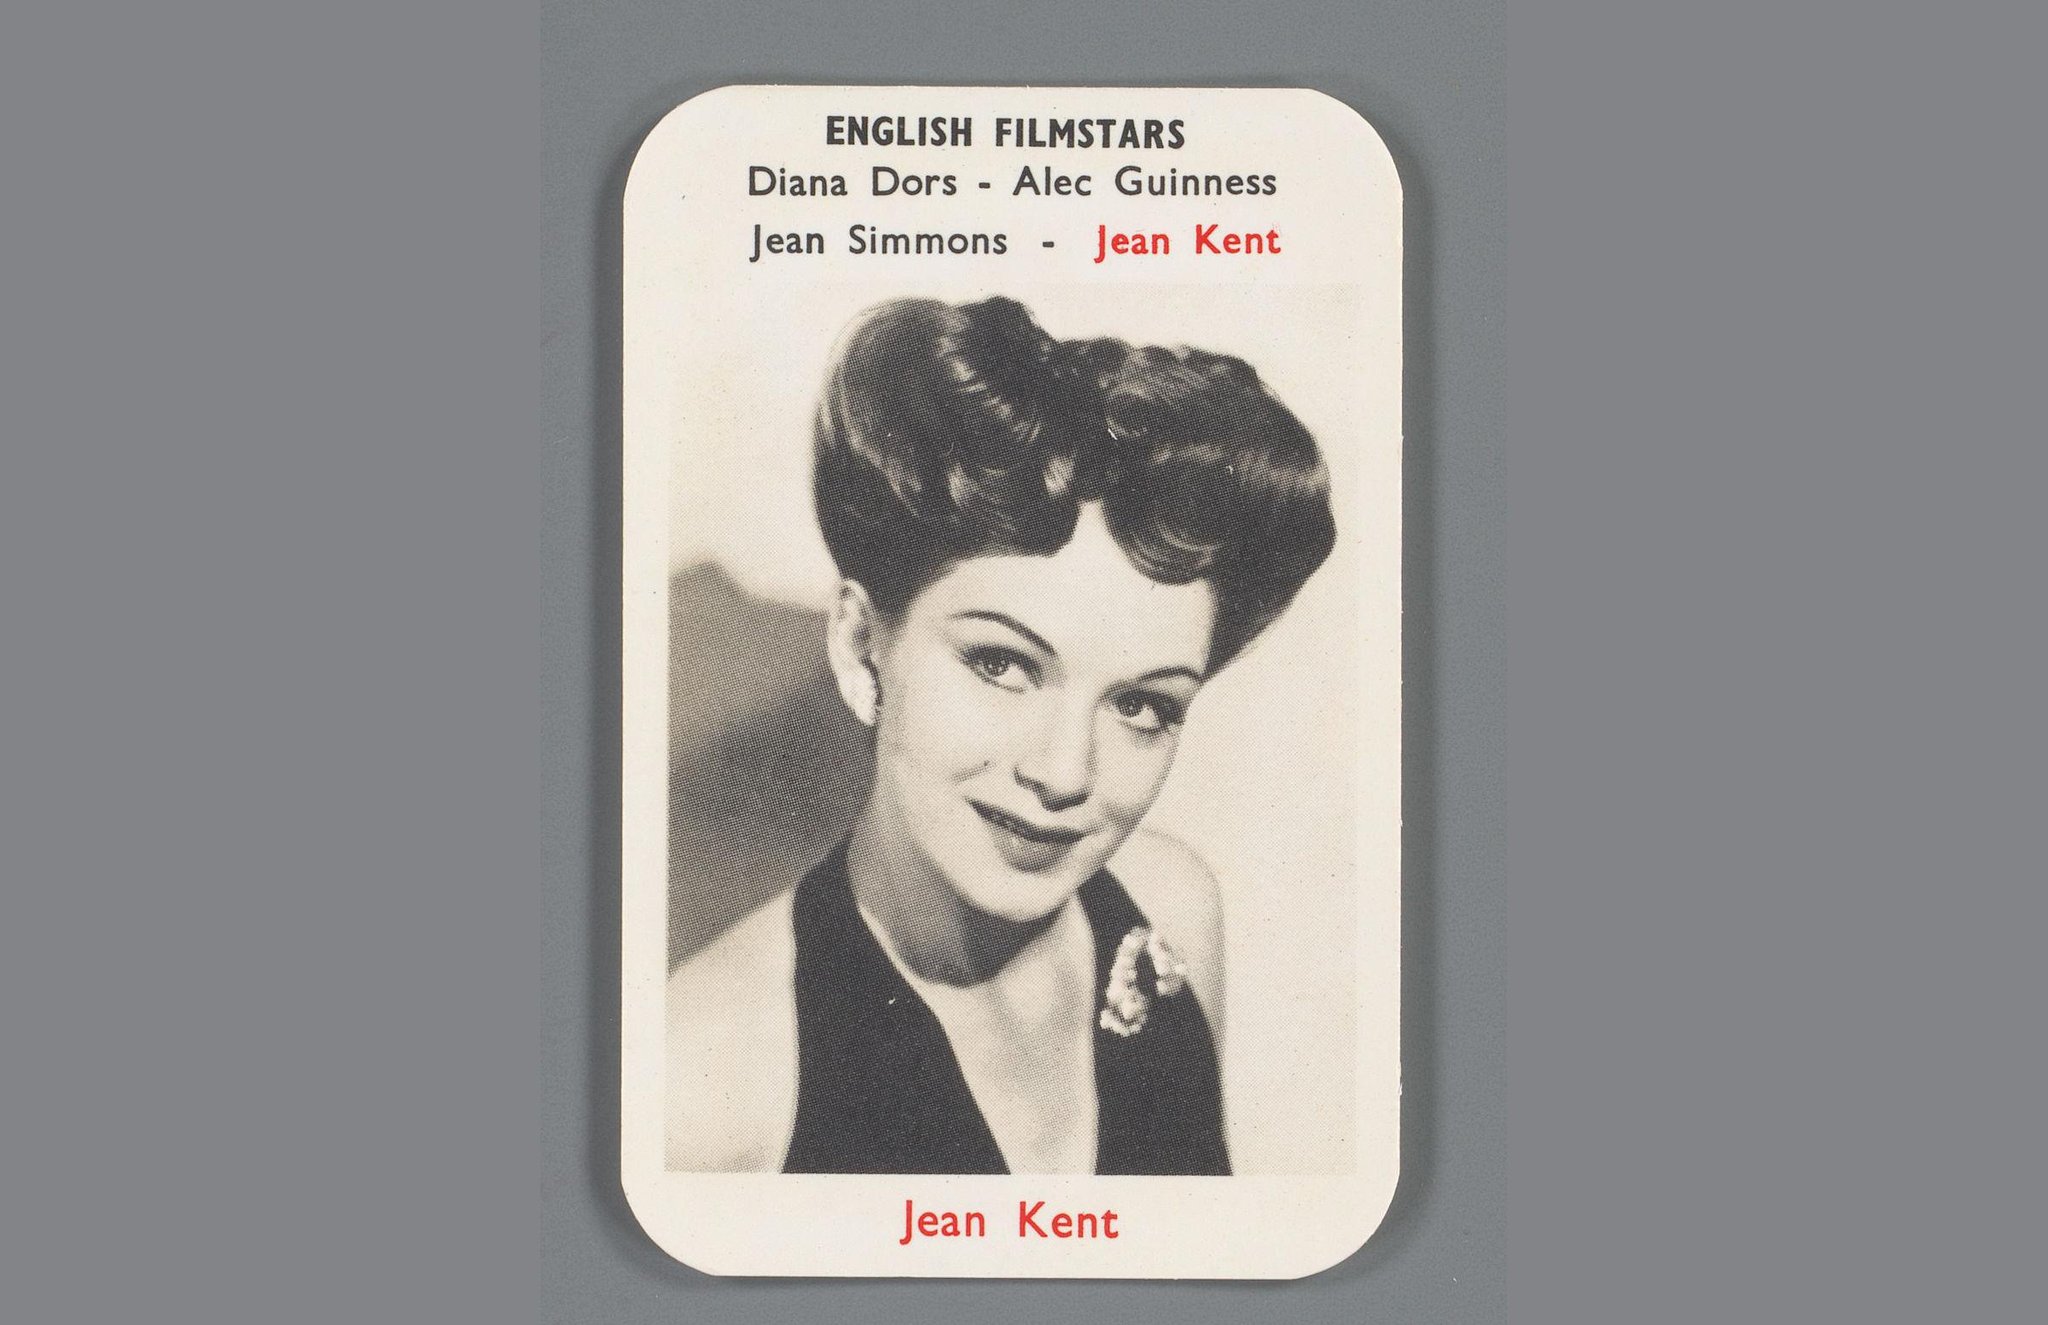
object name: photomechanical print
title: English Filmstars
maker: Anonymous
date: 1960-1970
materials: paper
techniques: autotype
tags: portrait of actor, actress